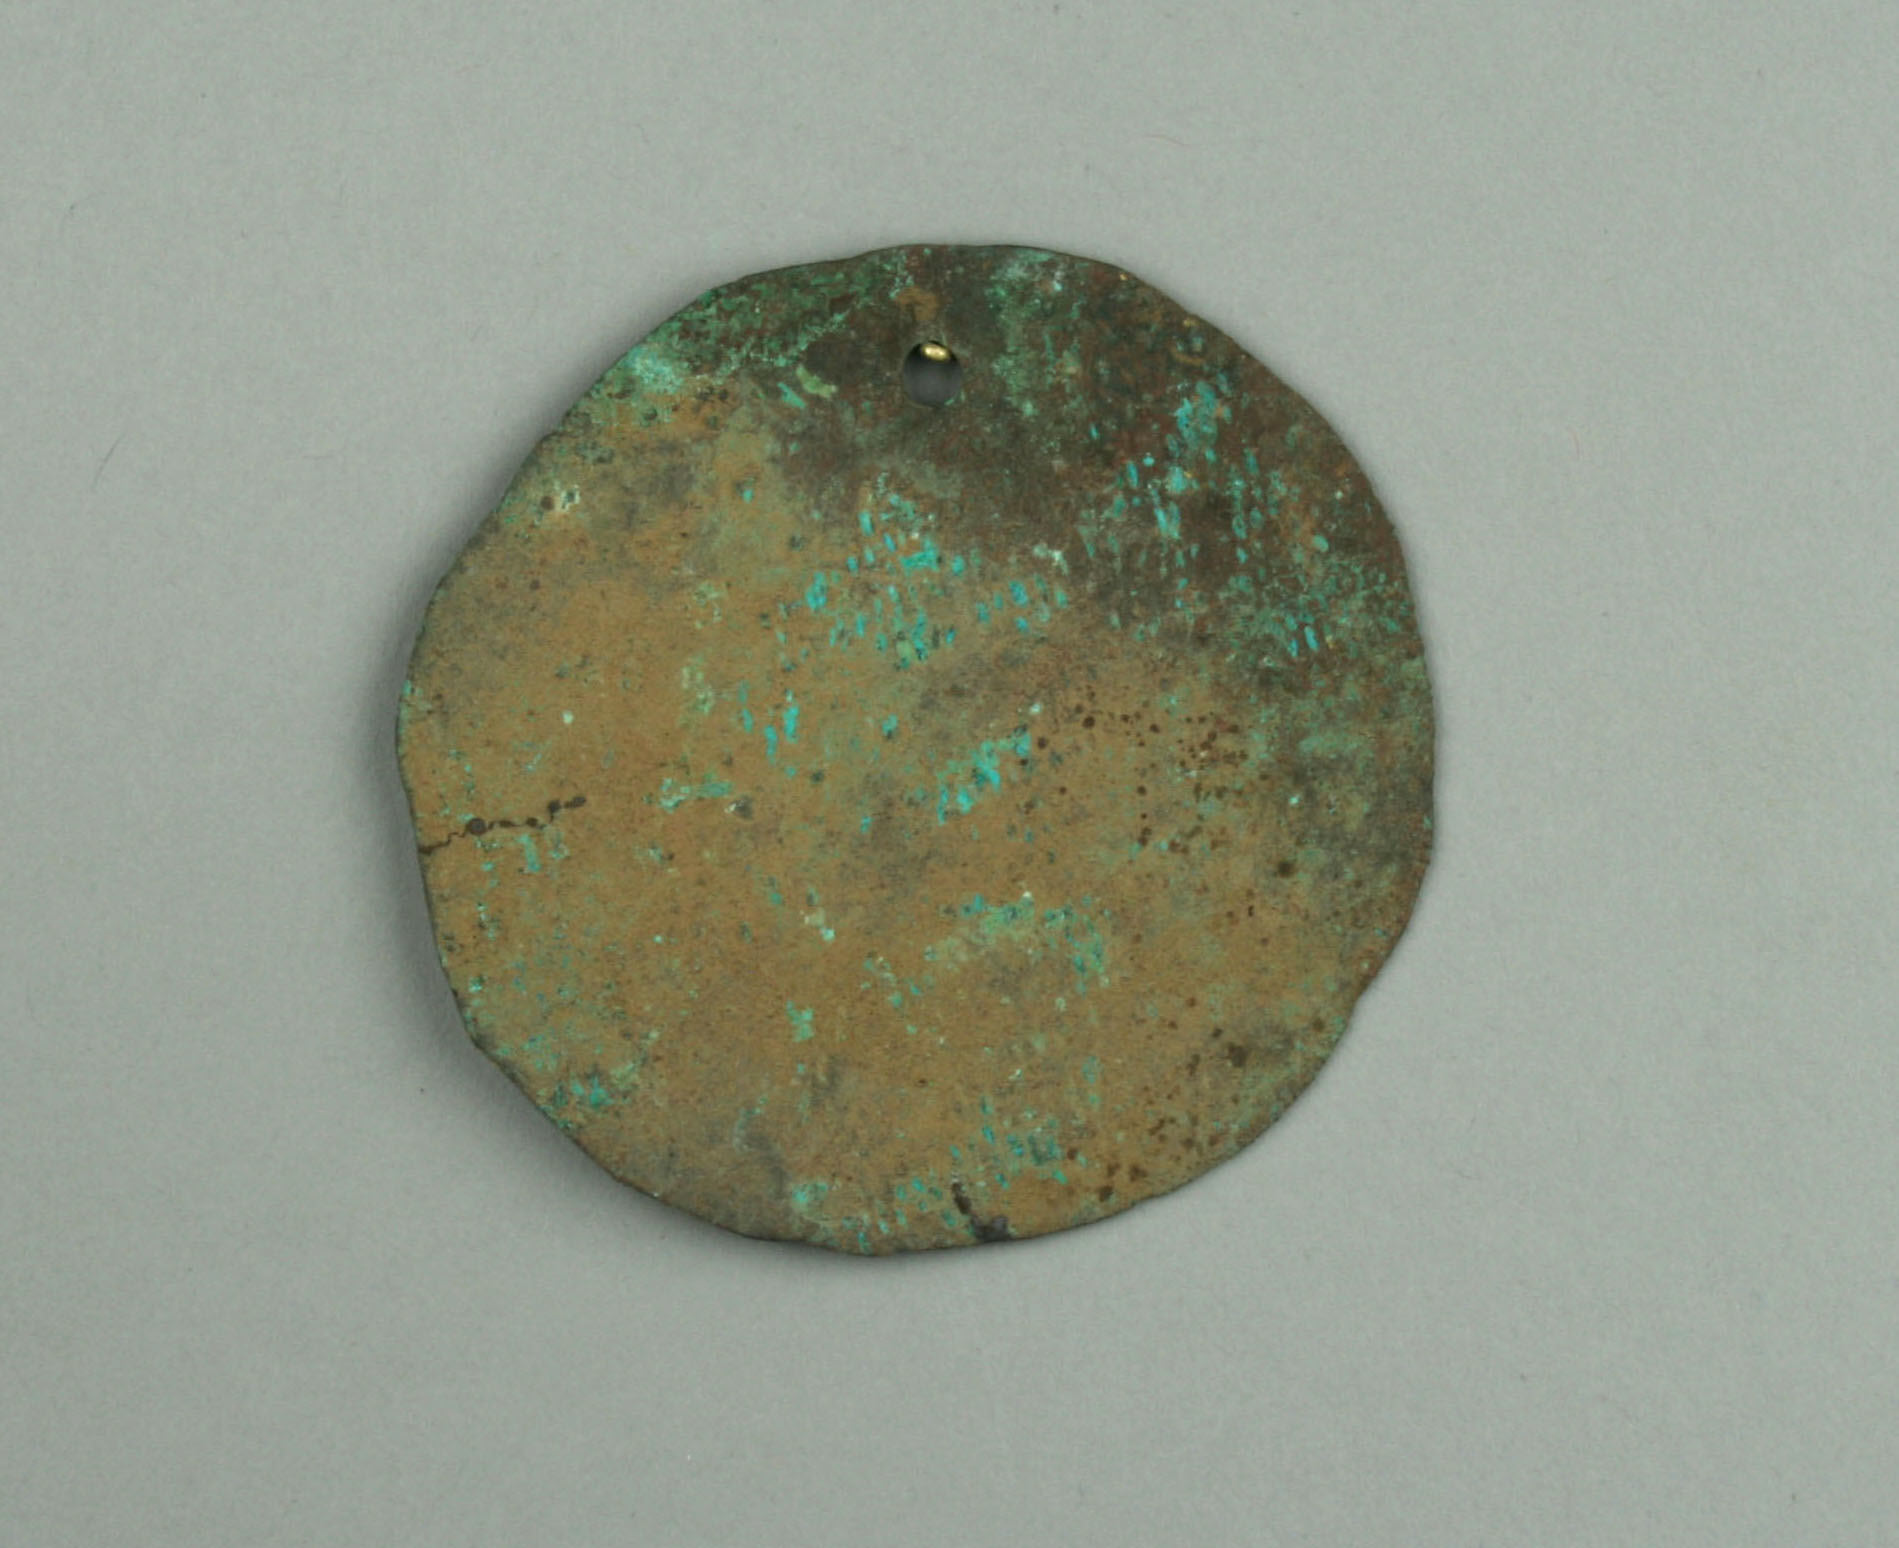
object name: plaque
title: Round Plaque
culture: vicús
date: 300 BCE-200 CE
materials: copper, gilt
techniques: hammering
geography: peru